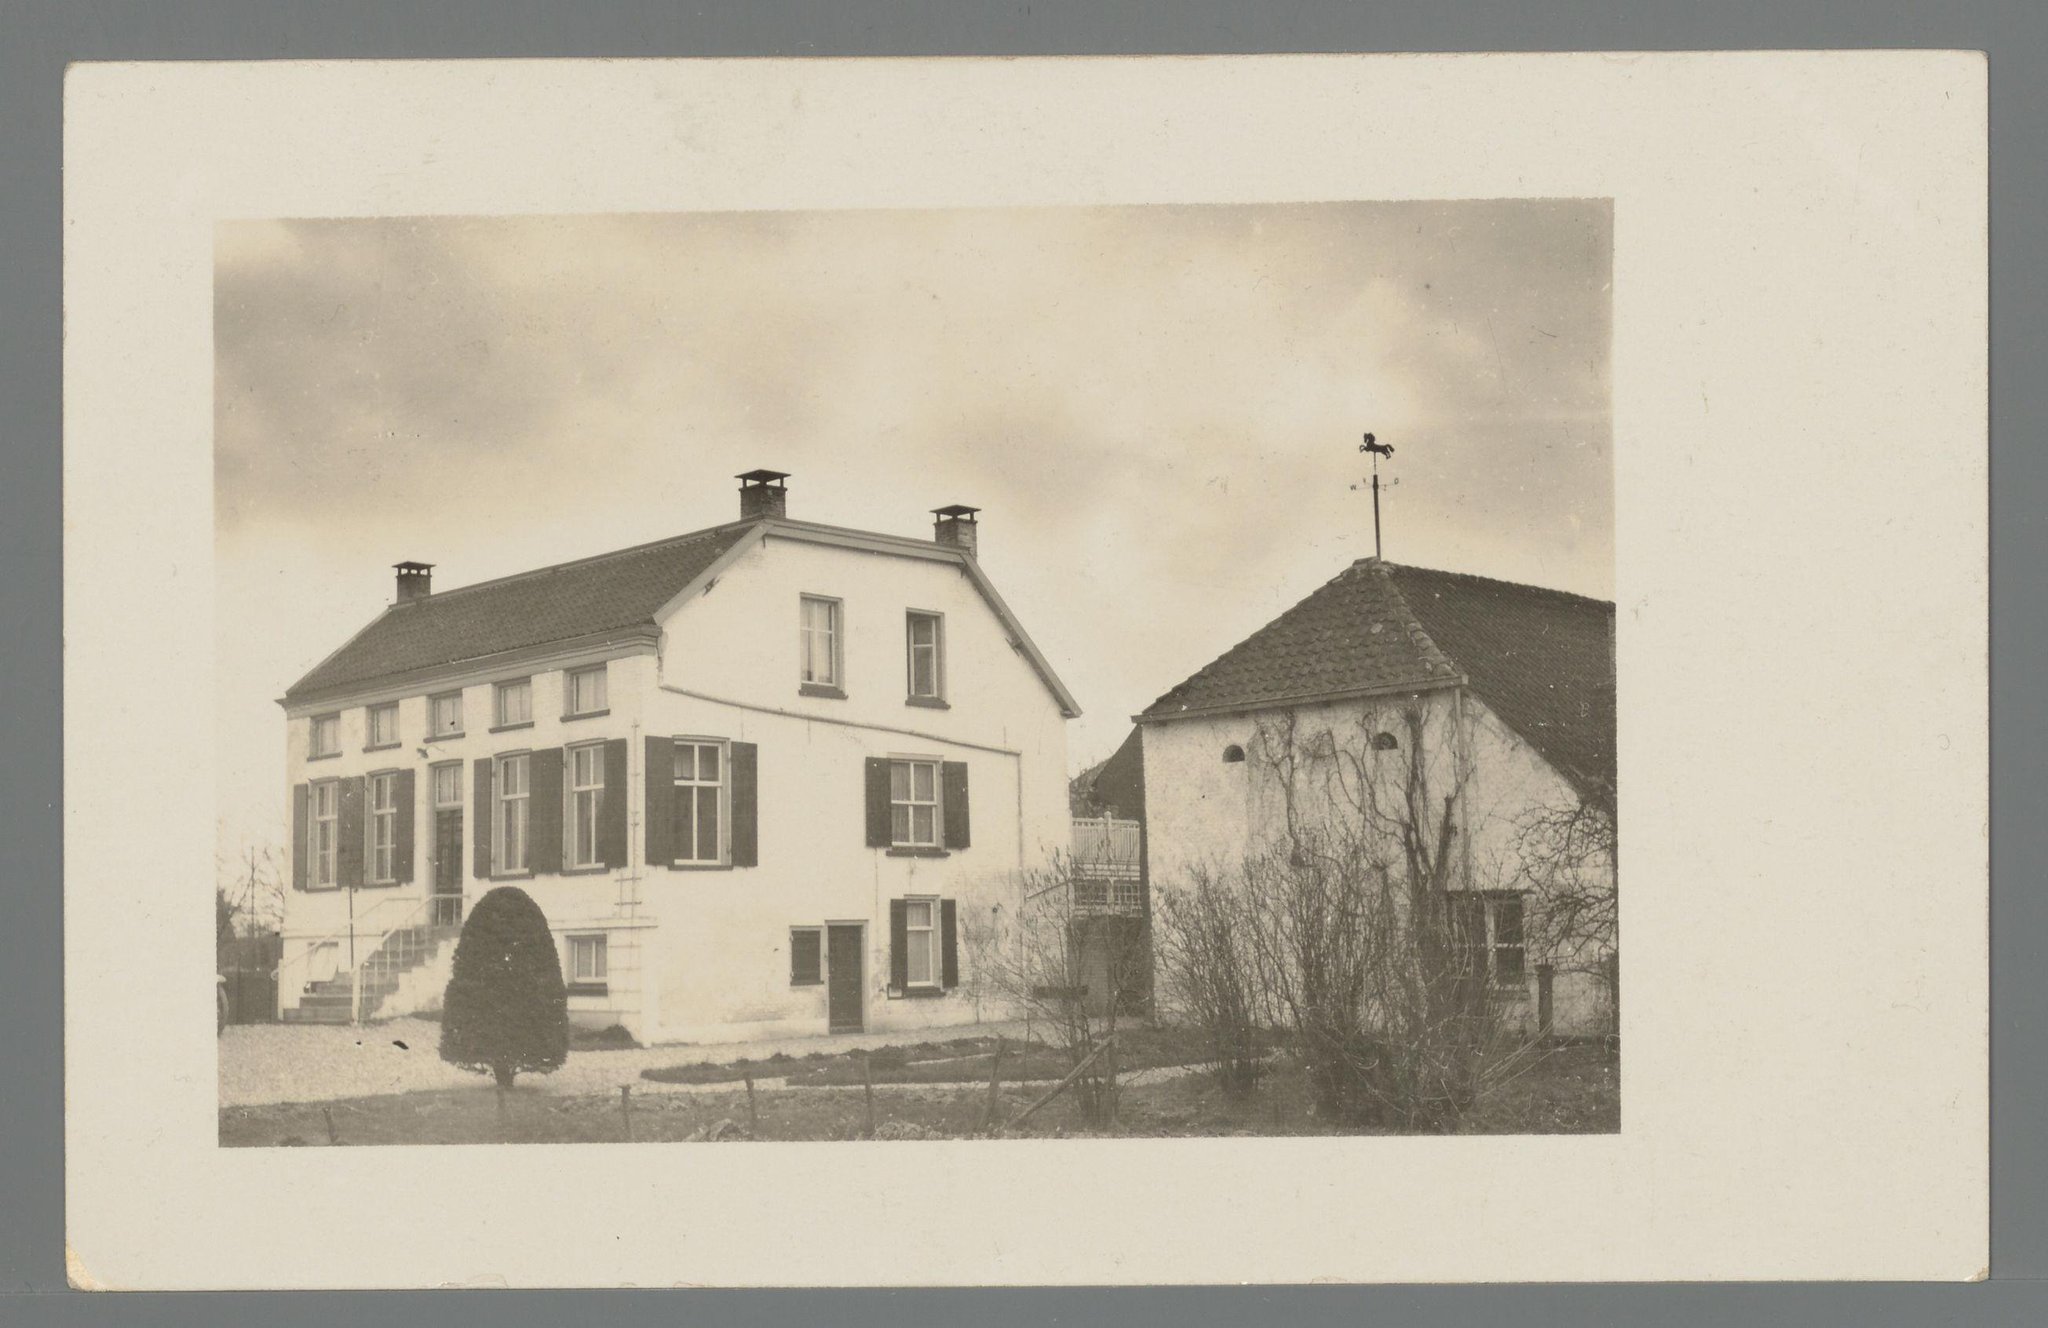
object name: photograph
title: Gezicht op huizen in Rossum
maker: Anonymous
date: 1905-1928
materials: paper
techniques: gelatin silver print, writing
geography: renkum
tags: street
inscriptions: postage stamp